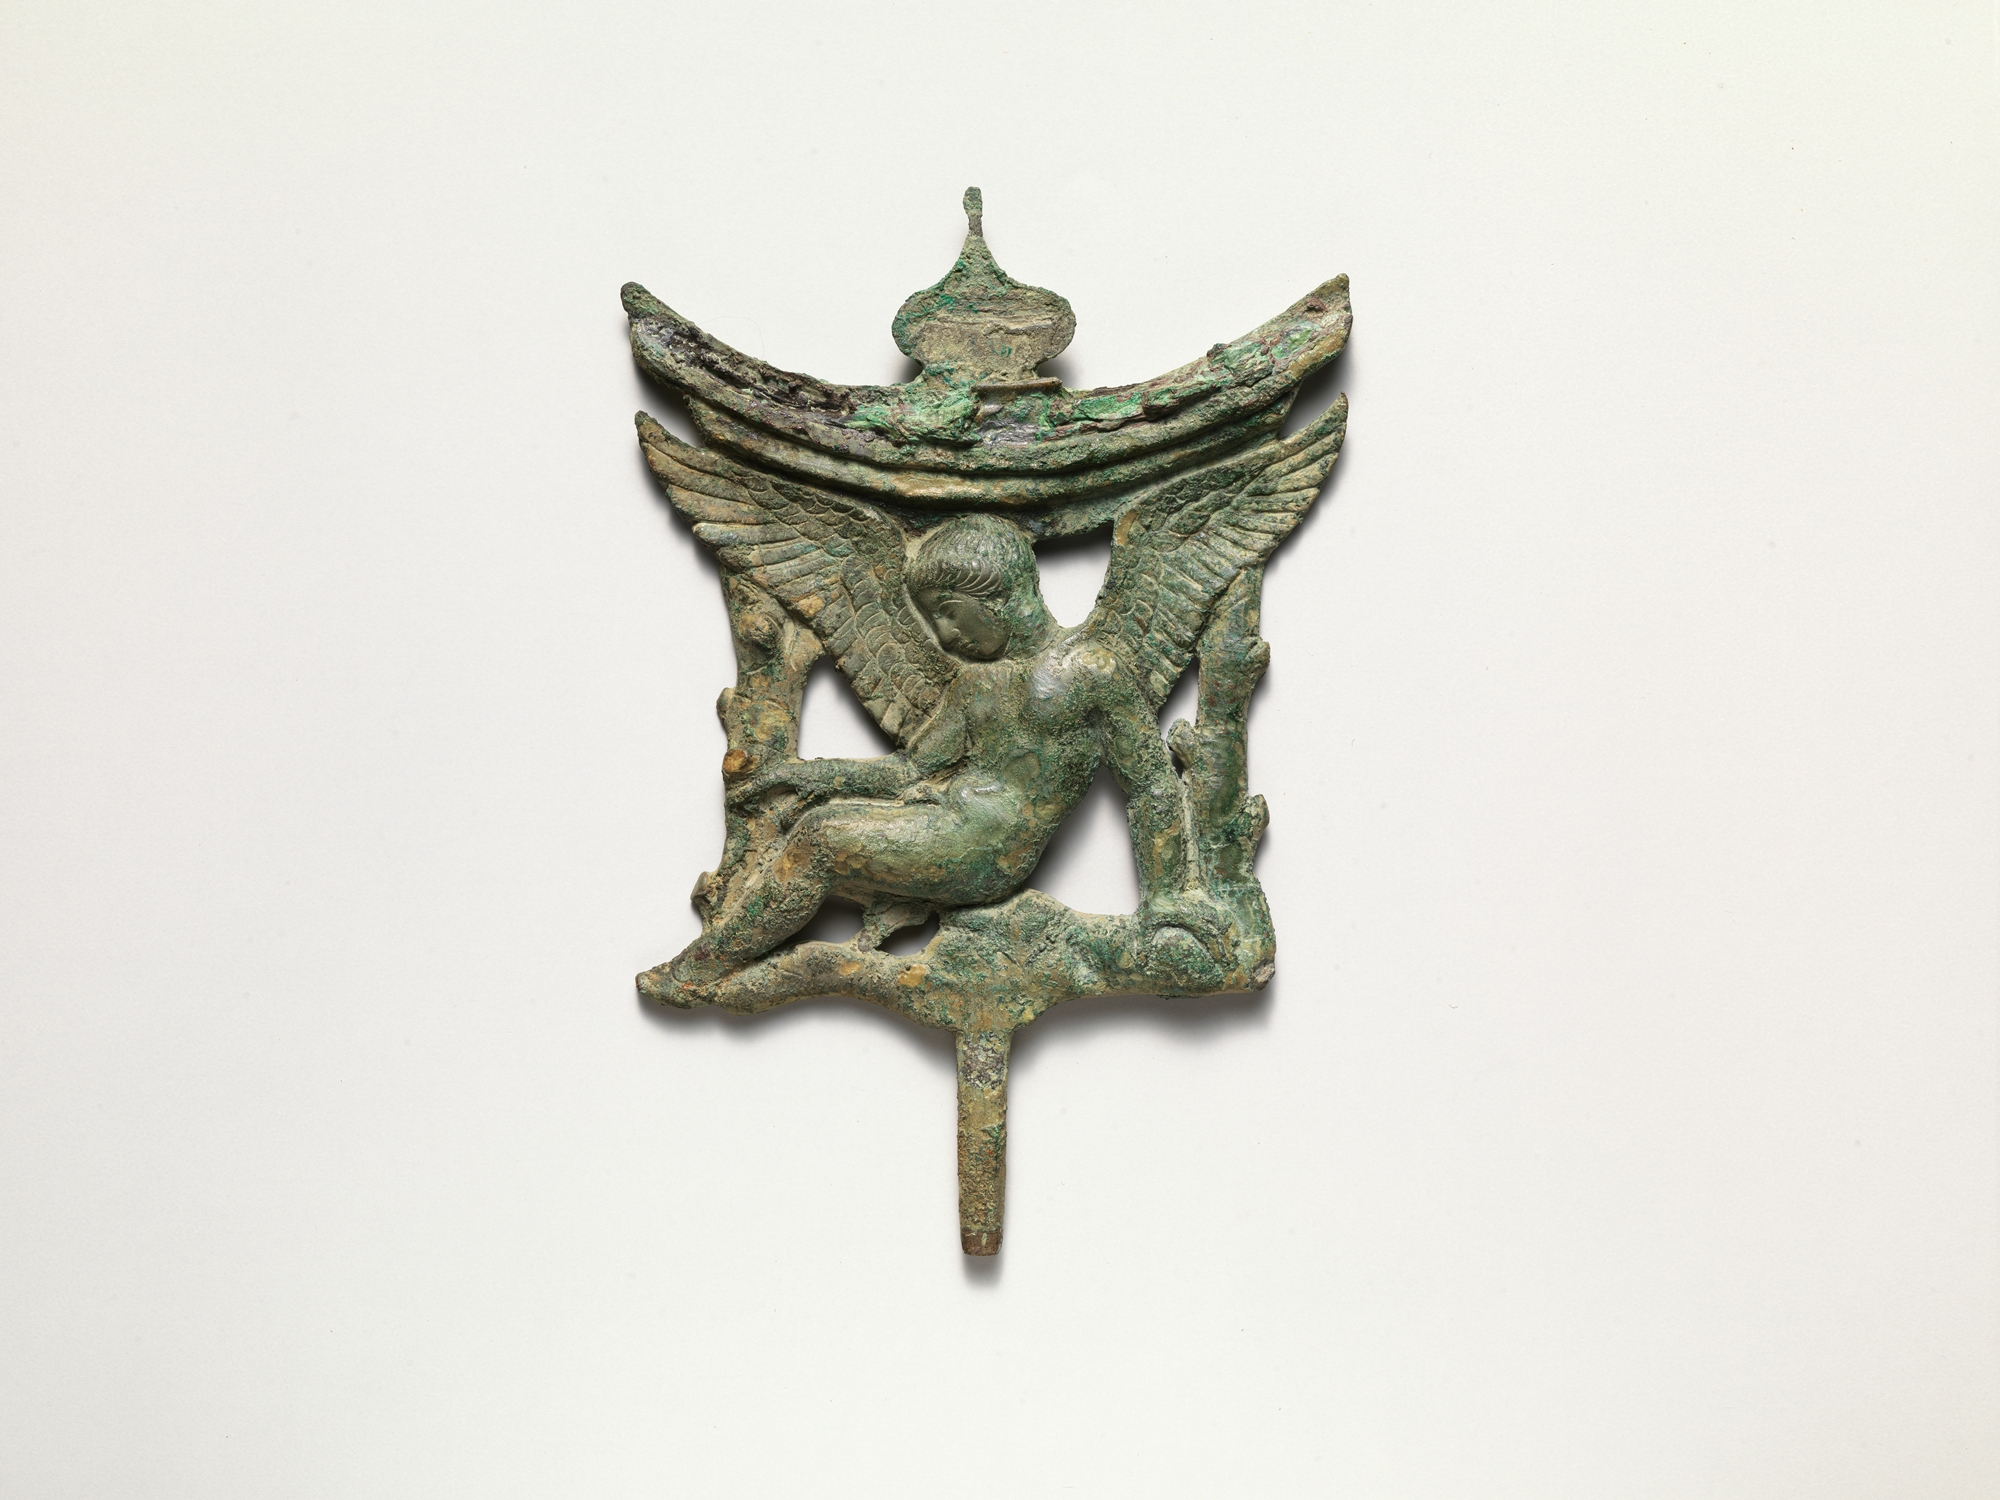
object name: mirror support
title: Bronze support for a mirror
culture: greek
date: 400-301 BCE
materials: bronze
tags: eros